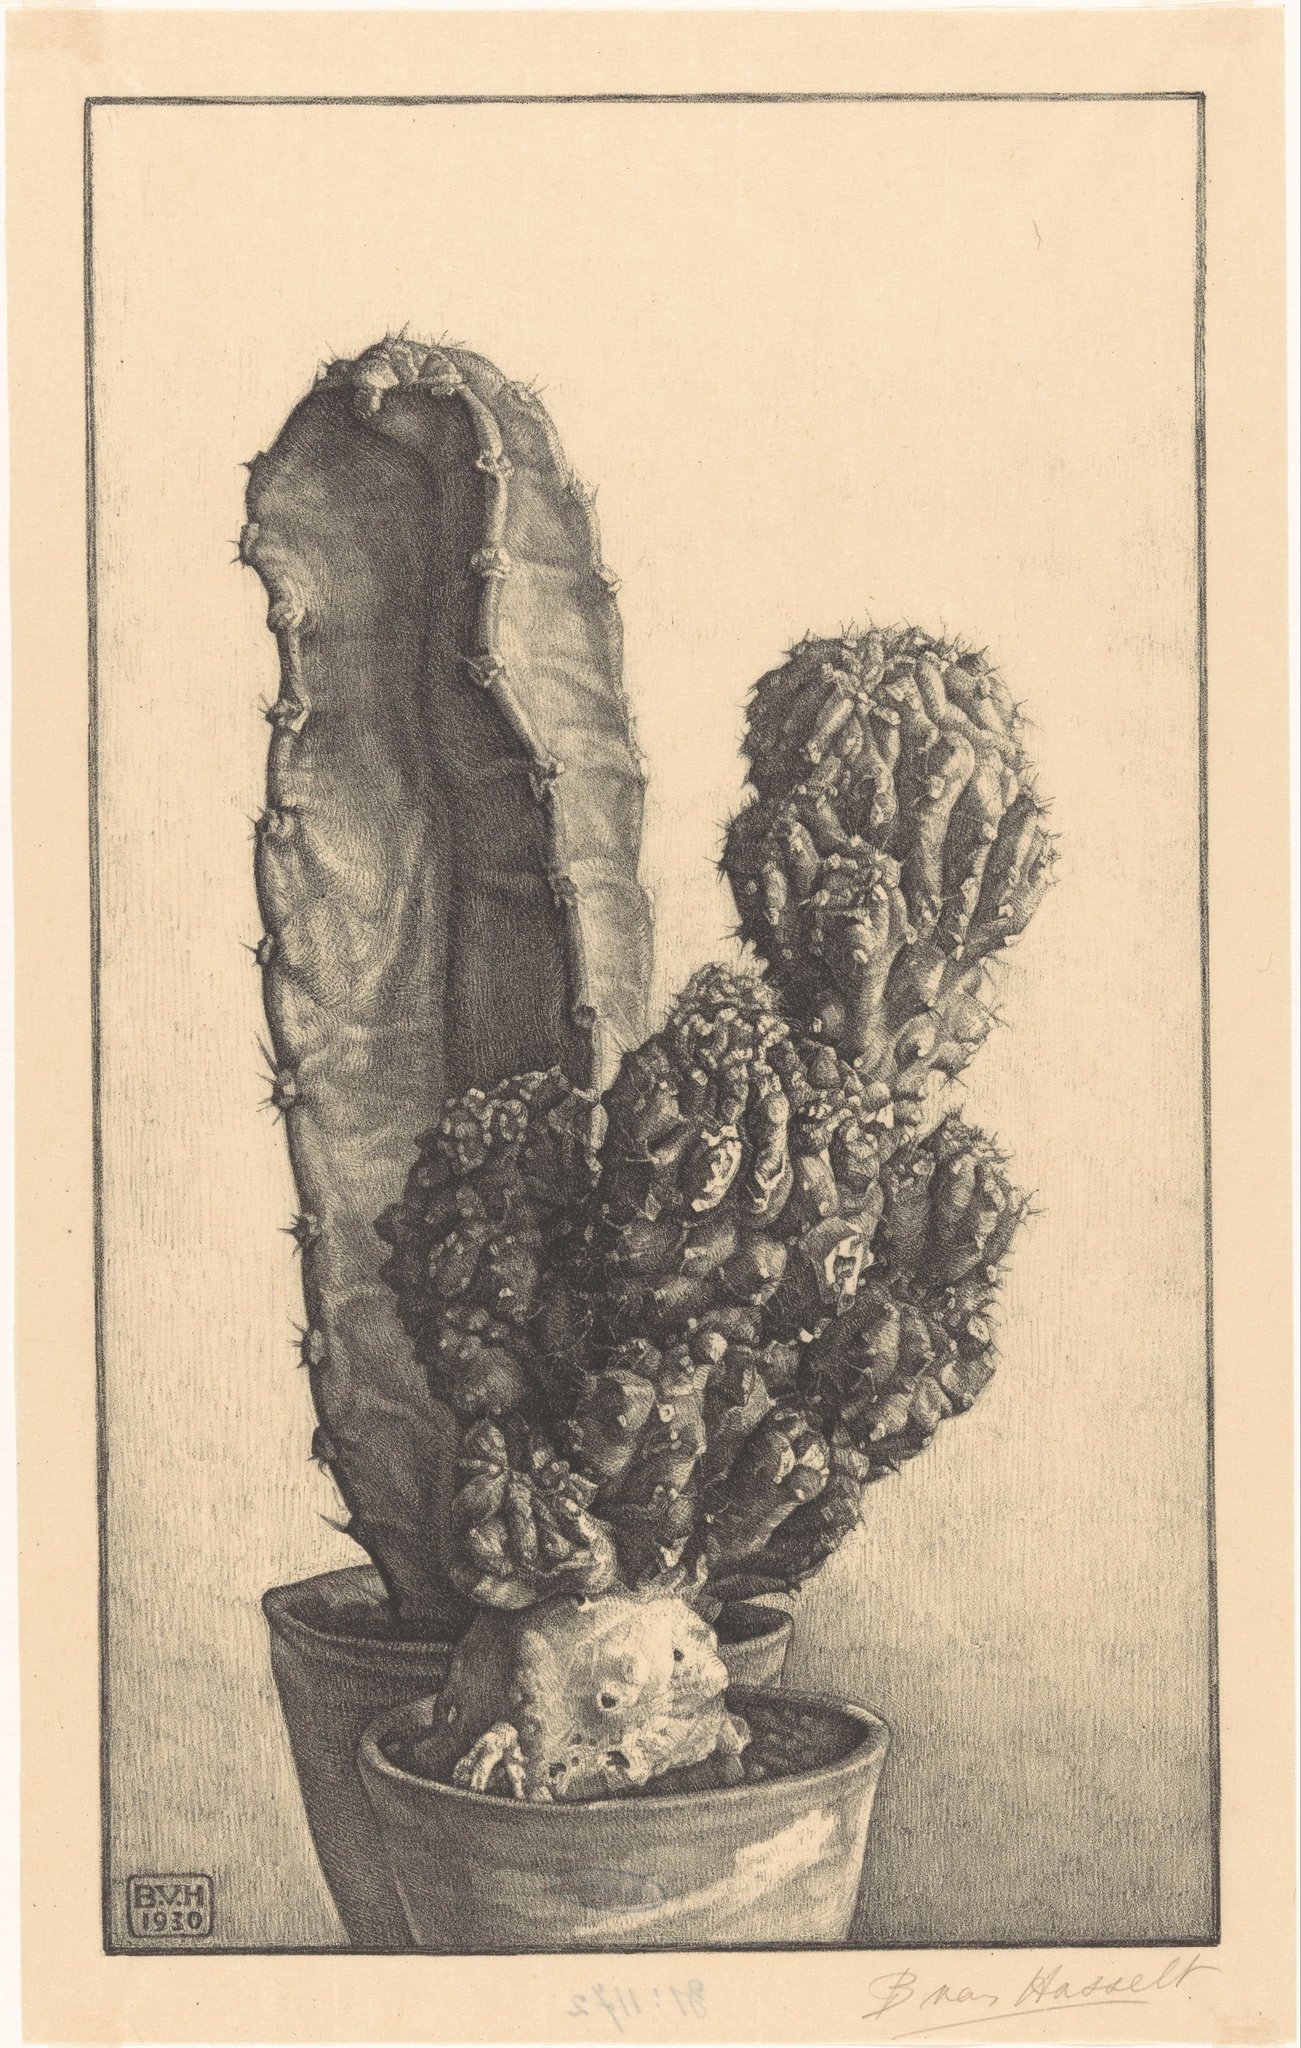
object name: print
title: Caktussen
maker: bertha van hasselt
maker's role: print maker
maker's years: 1878-1932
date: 1930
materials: paper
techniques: lithograph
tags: plants and herbs: cactus, potted plants